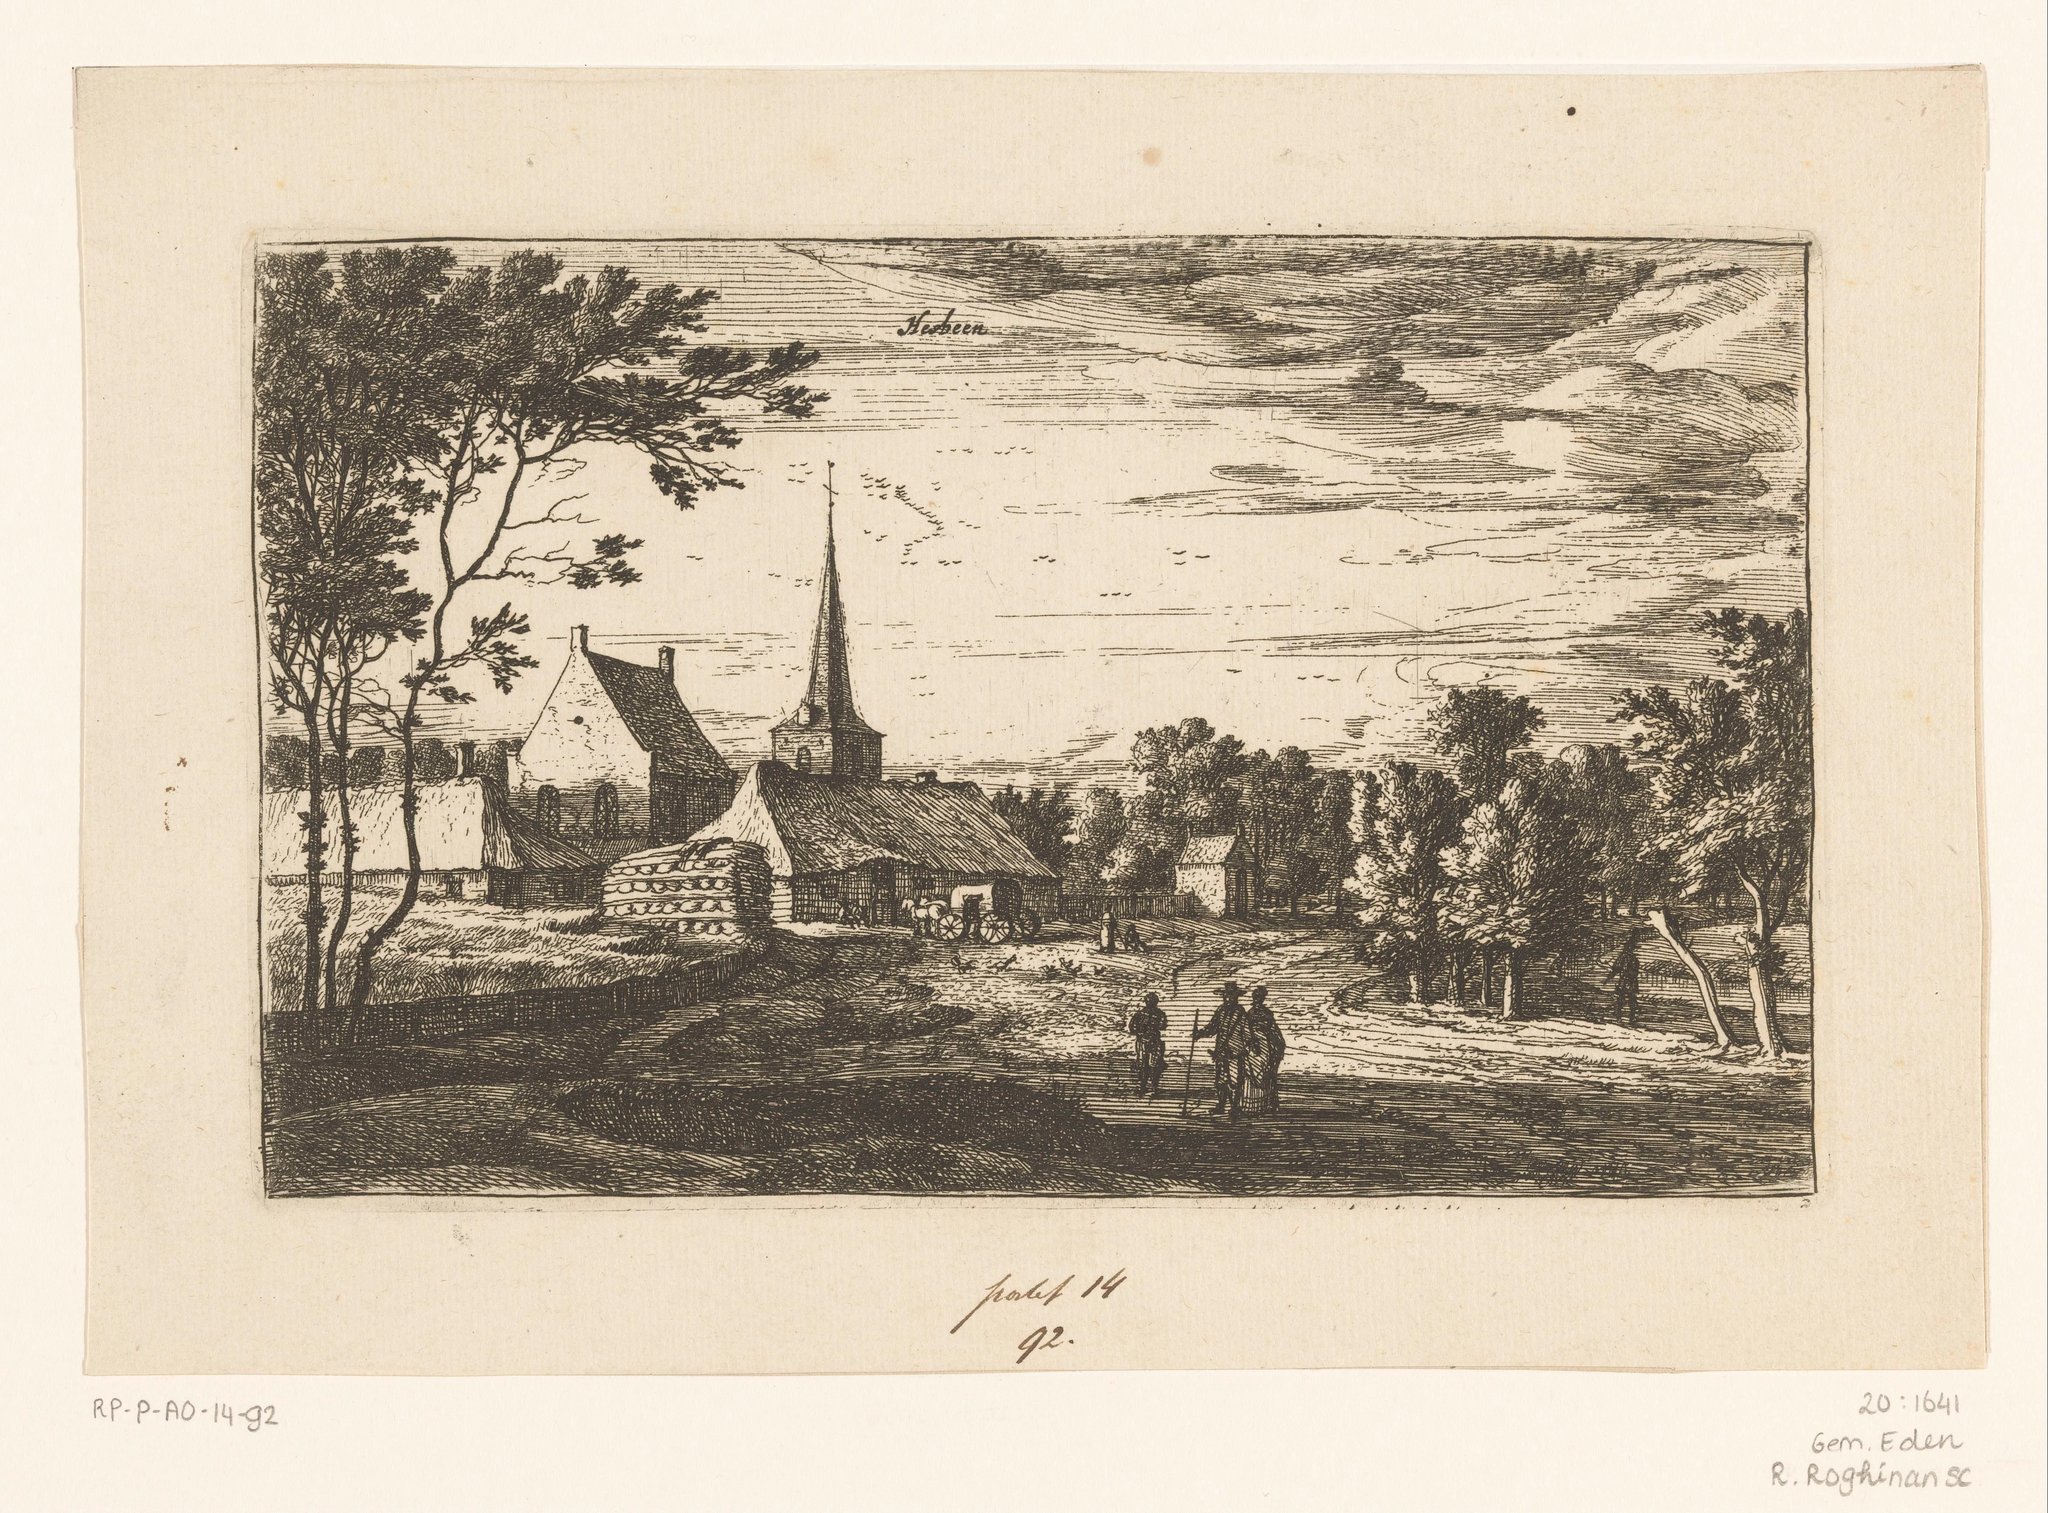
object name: print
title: Hesbeen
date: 1643-1677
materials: paper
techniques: etching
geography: amsterdam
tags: prospect of village, silhouette of village, church (exterior)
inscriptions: collector's mark: Lugt 2233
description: Gezicht op het dorp Heesbeen bij Heusden. Links het dorp met de kerk en op de voorgrond enkele passanten. Rechtsonder genummerd: 2.